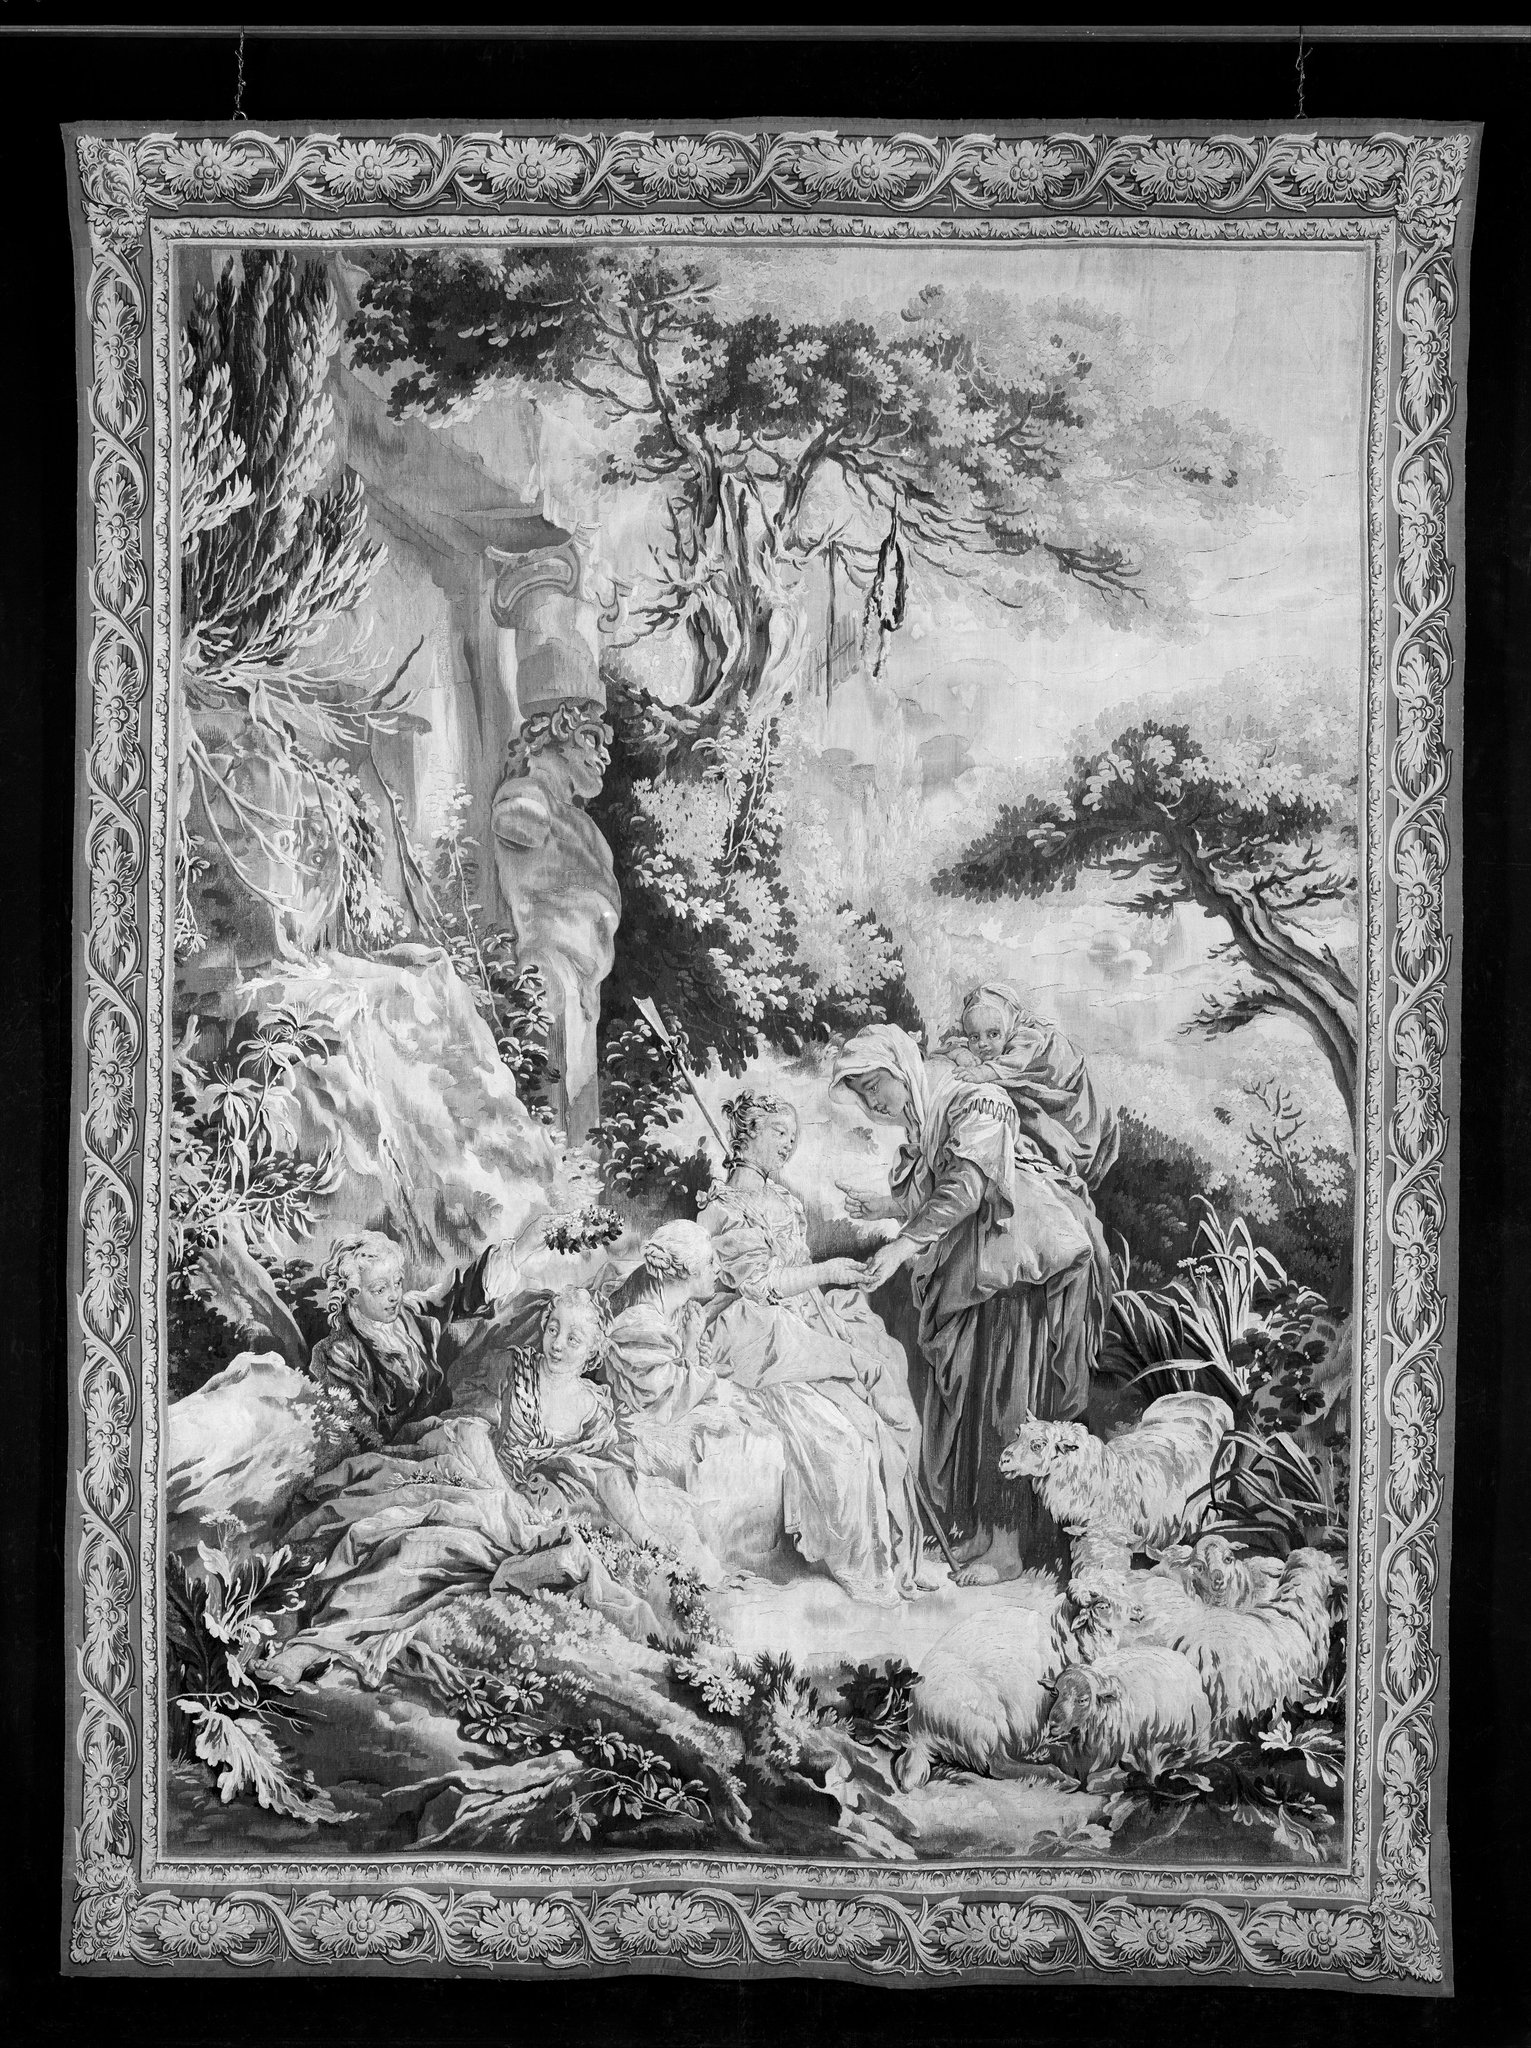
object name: tapestry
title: The Gypsy Fortune-Teller from a set of the Italian Village Scenes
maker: françois boucher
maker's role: artist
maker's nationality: french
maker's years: 1703-1770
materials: silk, wool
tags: children,men,women,sheep